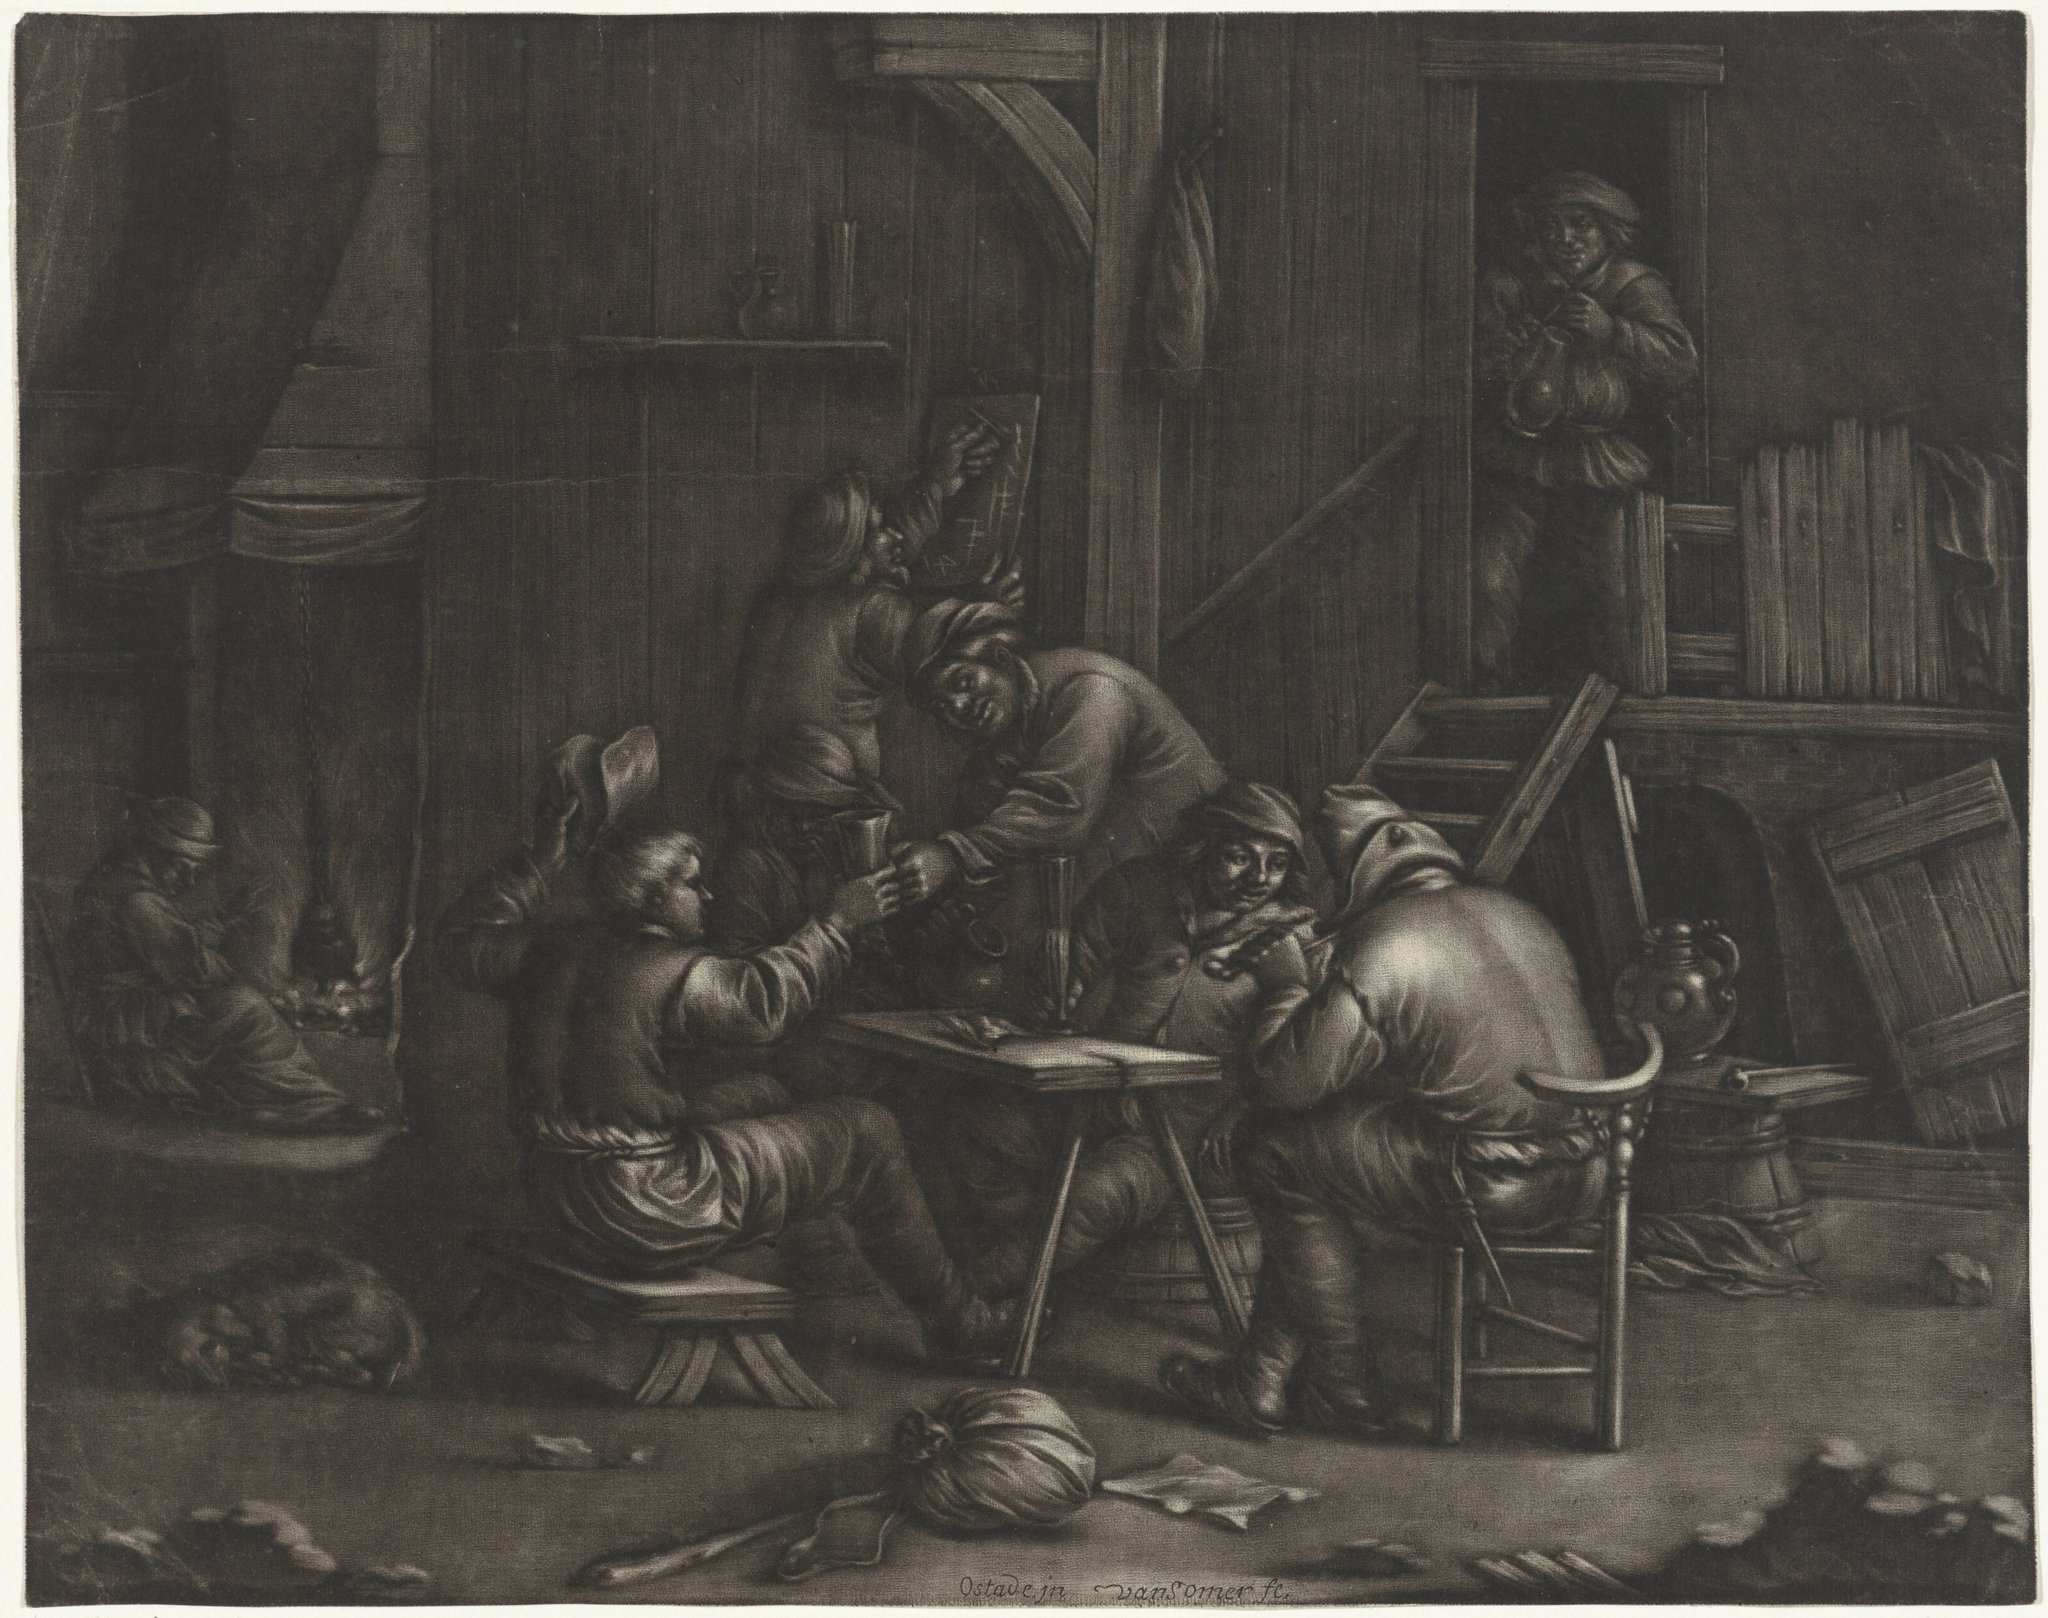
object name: print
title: Herberg met drinkende mannen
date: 1655-1700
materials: paper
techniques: mezzotint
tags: inn, coffee-house, public house, etc., pipe ~ tobacco, drinking, dog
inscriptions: collector's mark: Lugt 2228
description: In een herberg zitten mannen te praten en te drinken. Een man rookt een pijp en op de grond ligt een hond te slapen.